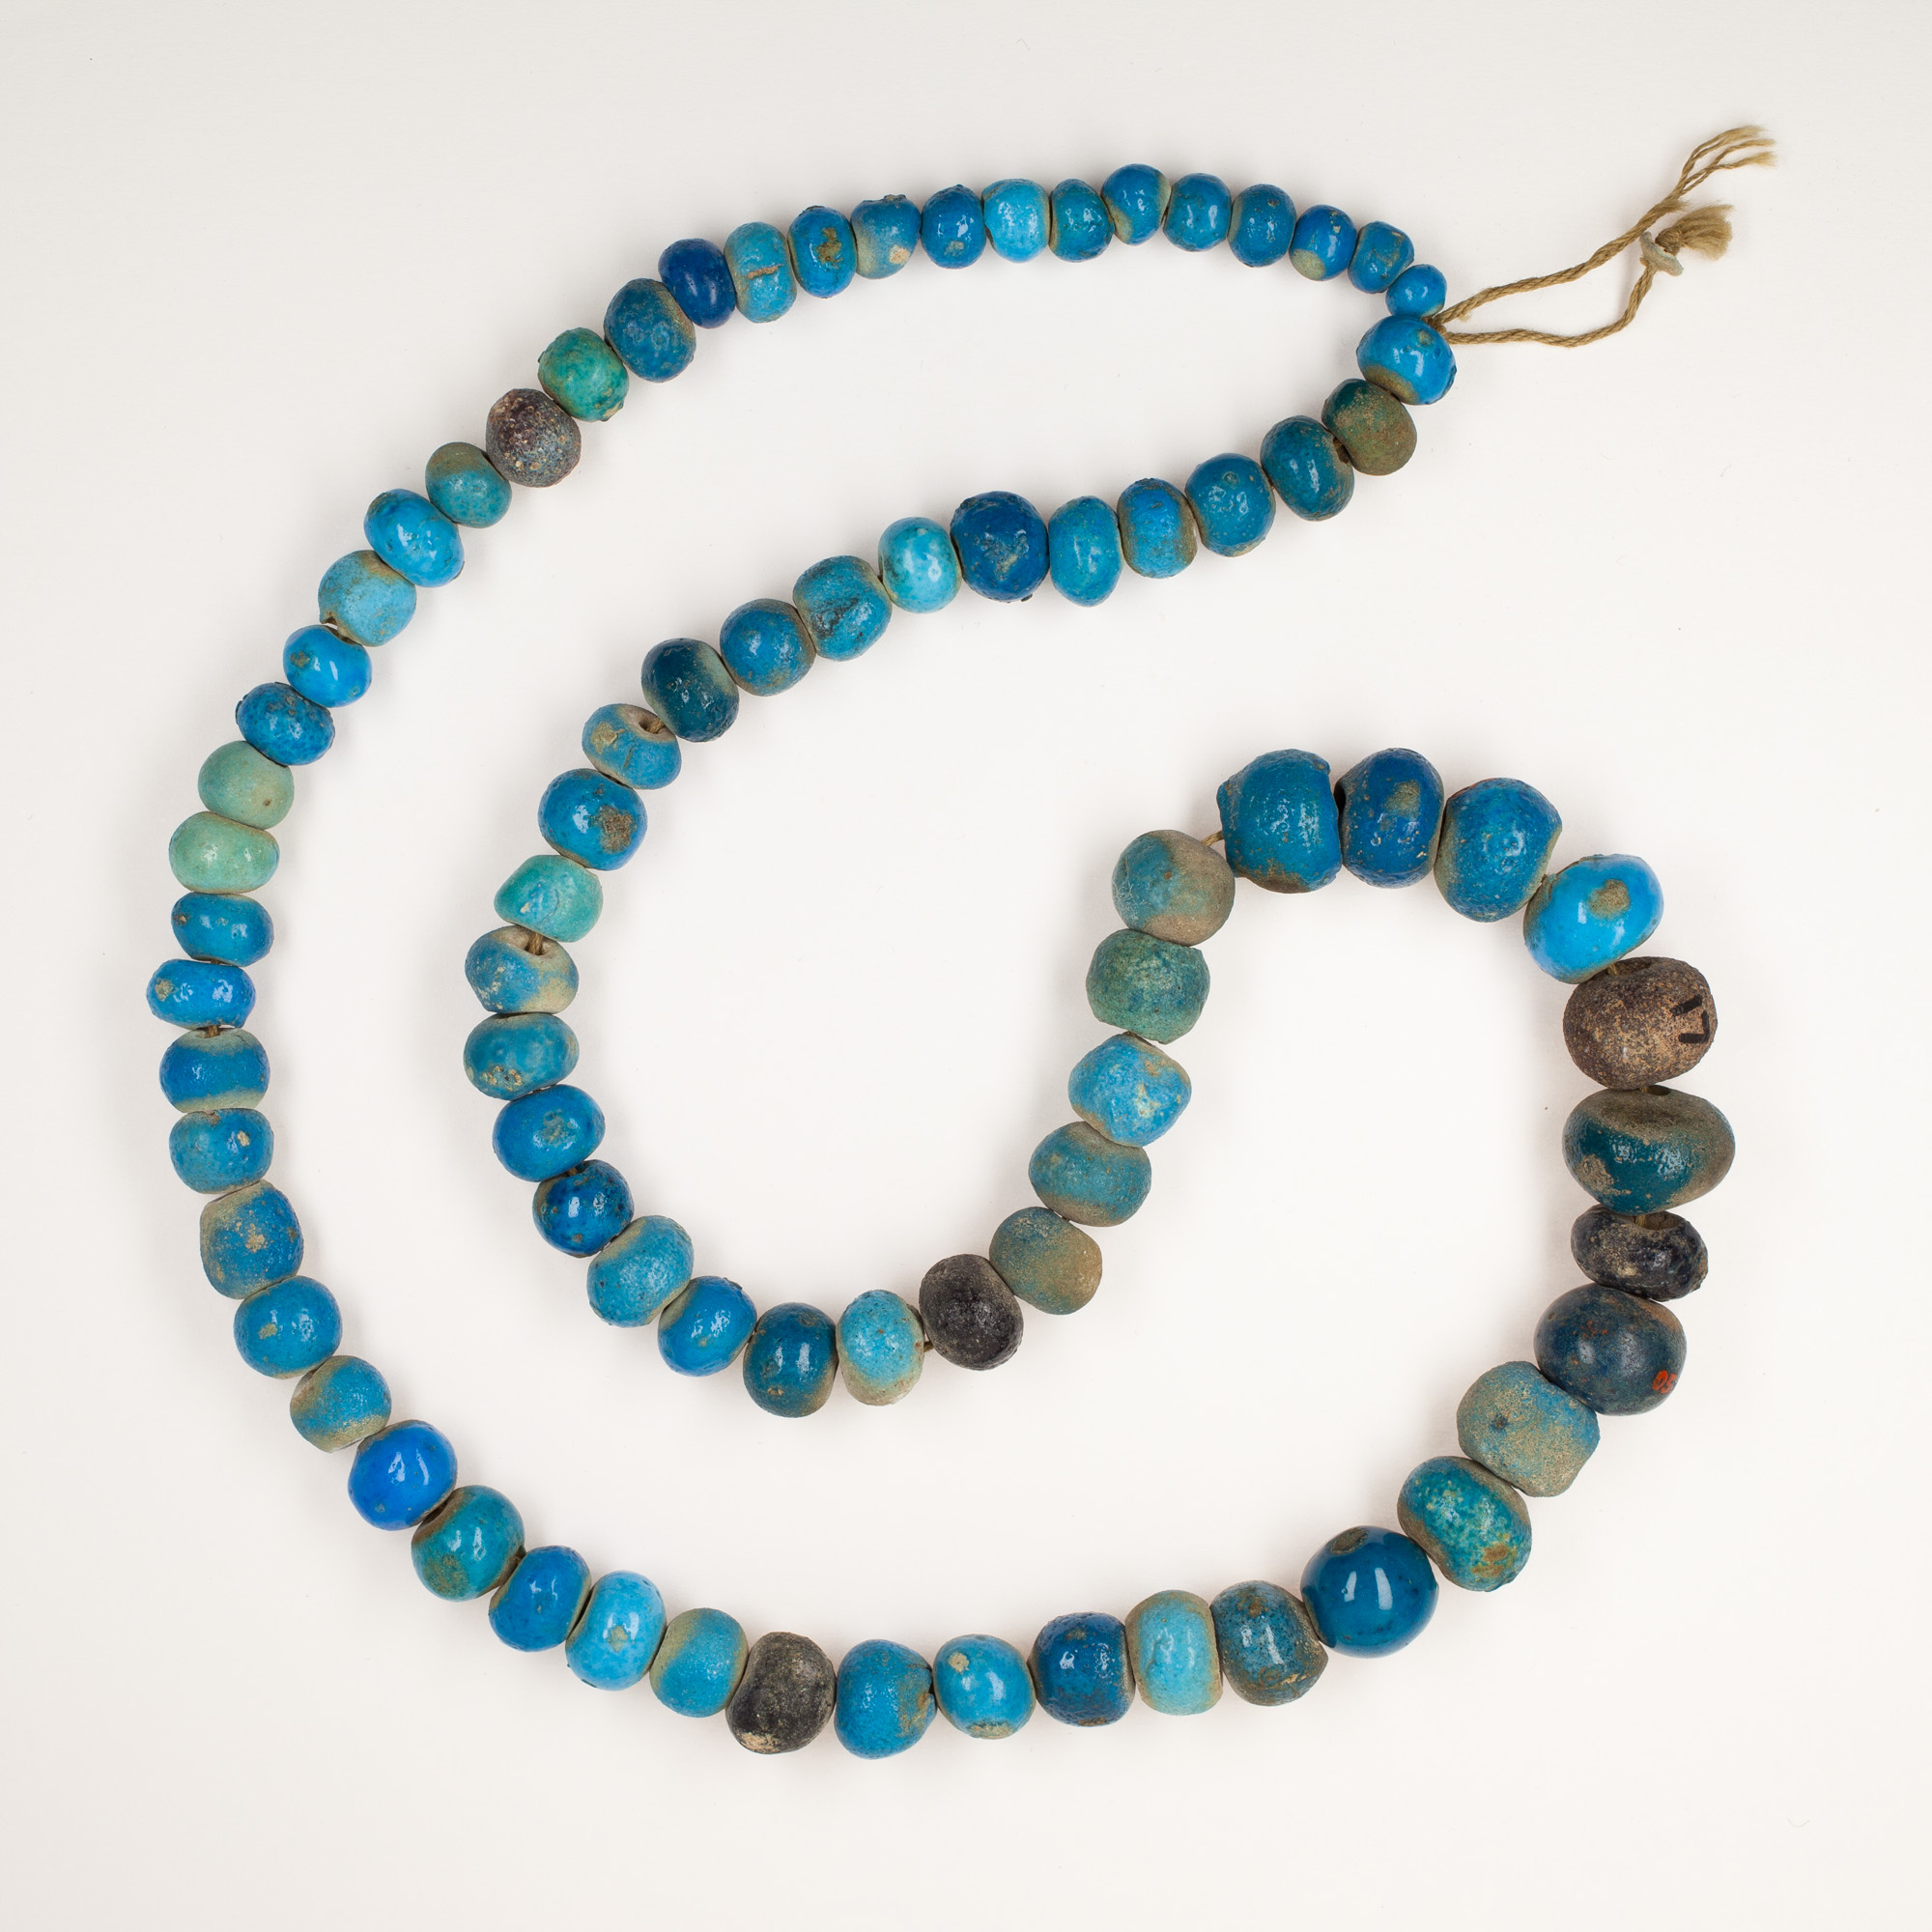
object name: bead, string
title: Beads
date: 1550-1295 BCE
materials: faience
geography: egypt